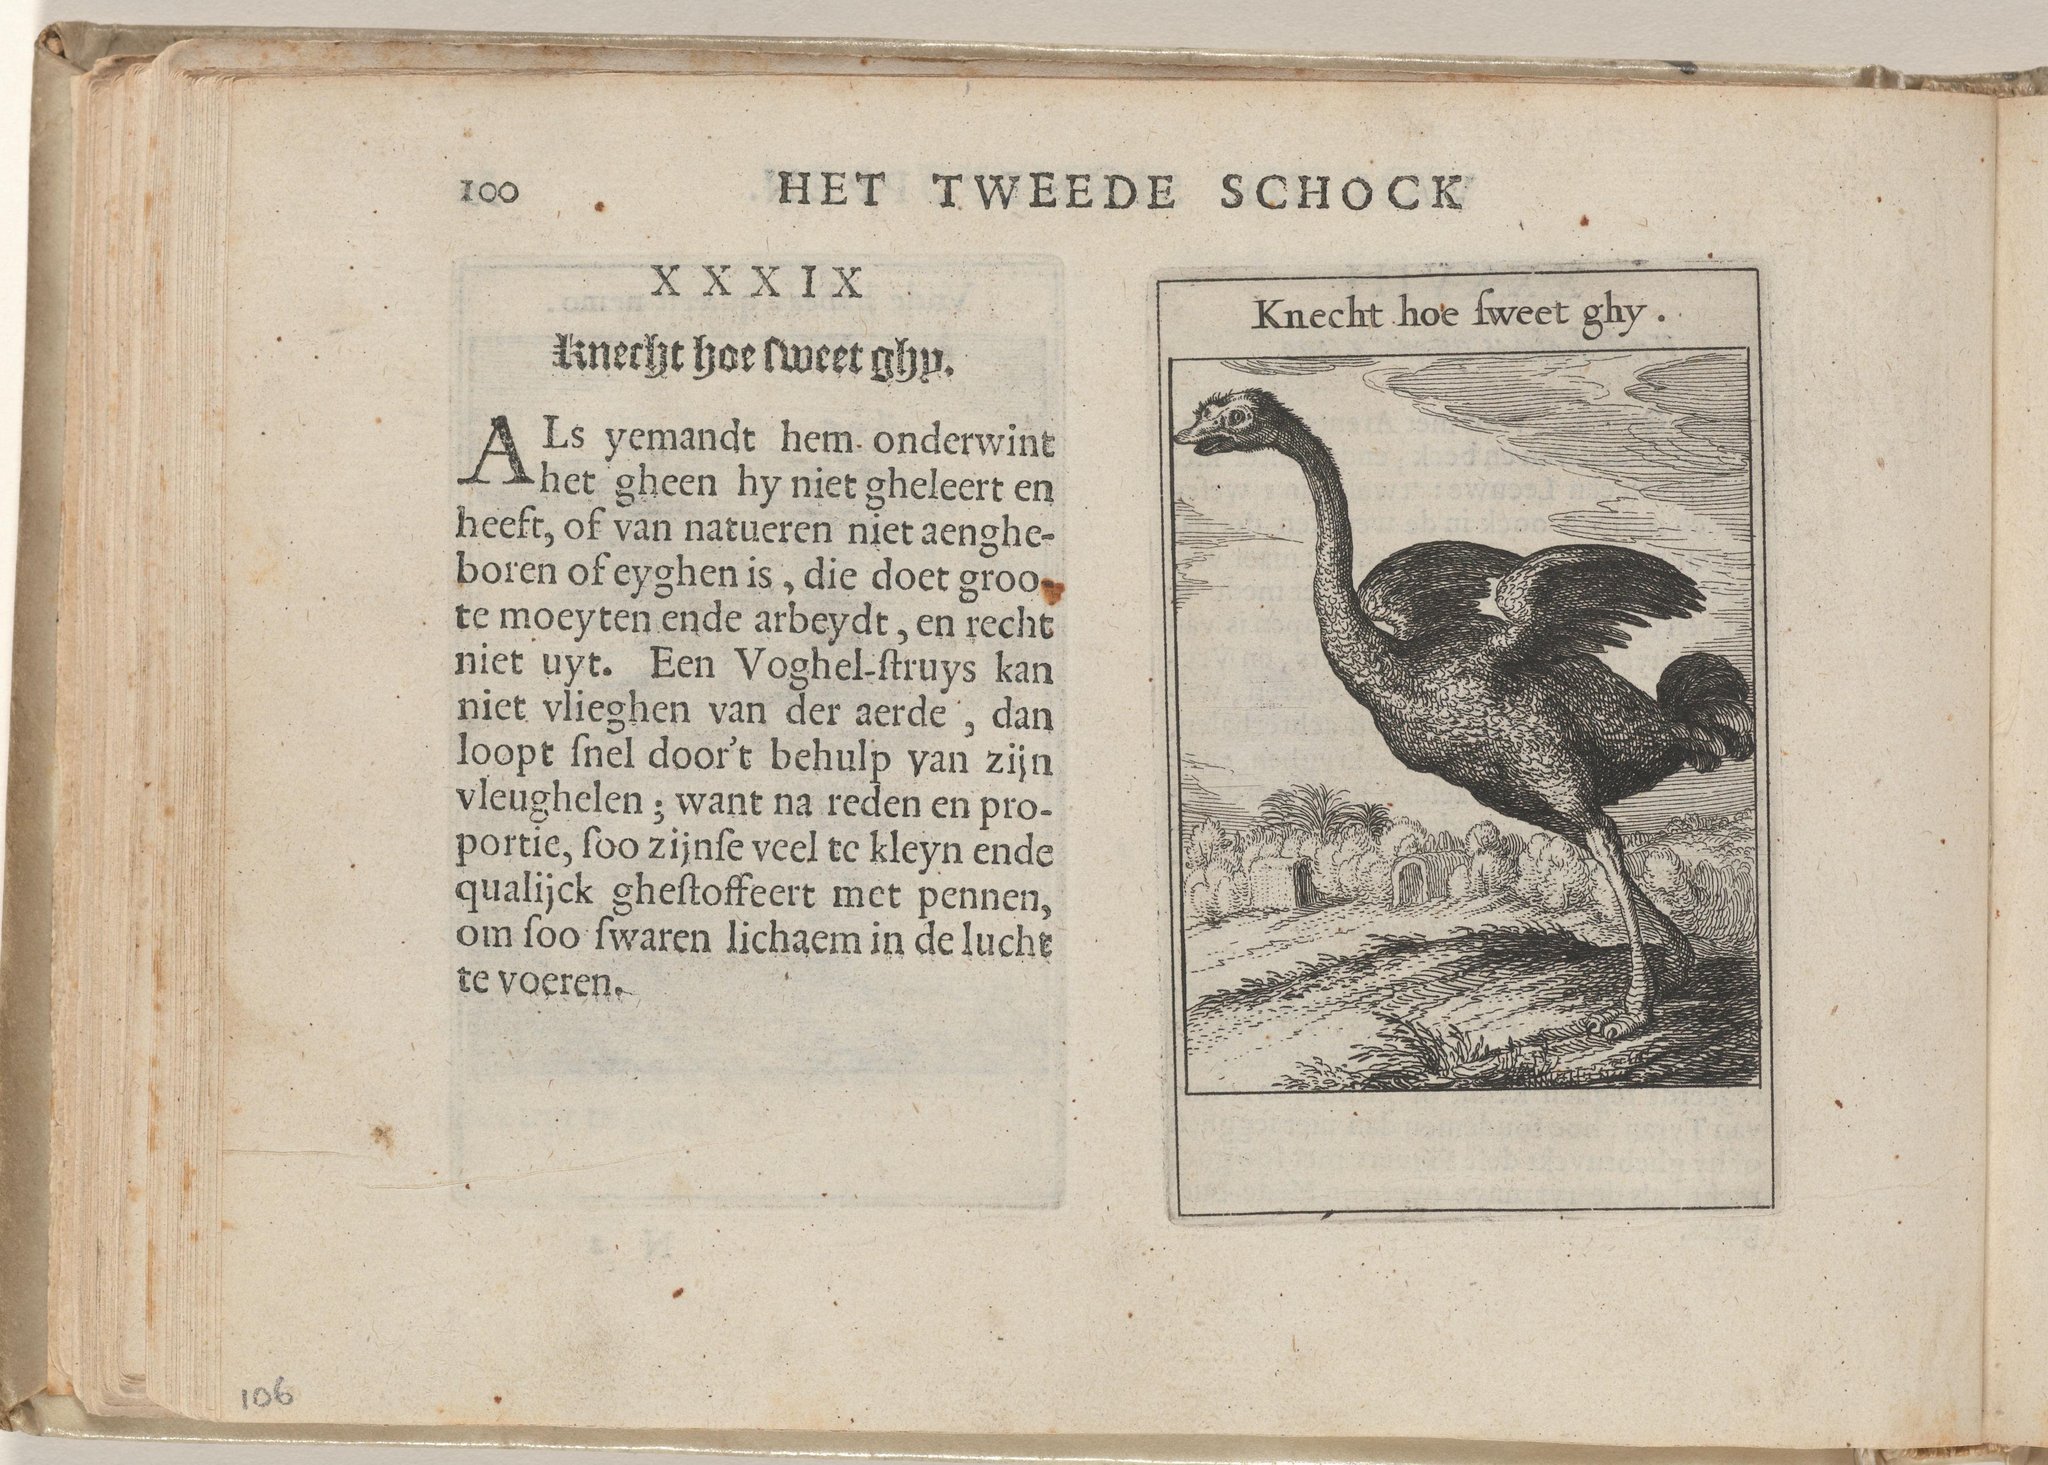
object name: album leaf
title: XXXIX Knecht hoe sweet ghy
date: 1614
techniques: engraving, printing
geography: amsterdam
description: XXXIX Knecht hoe sweet ghy. Tweede schok. Onderdeel van 'Sinnepoppen', R. Visscher, 1614.